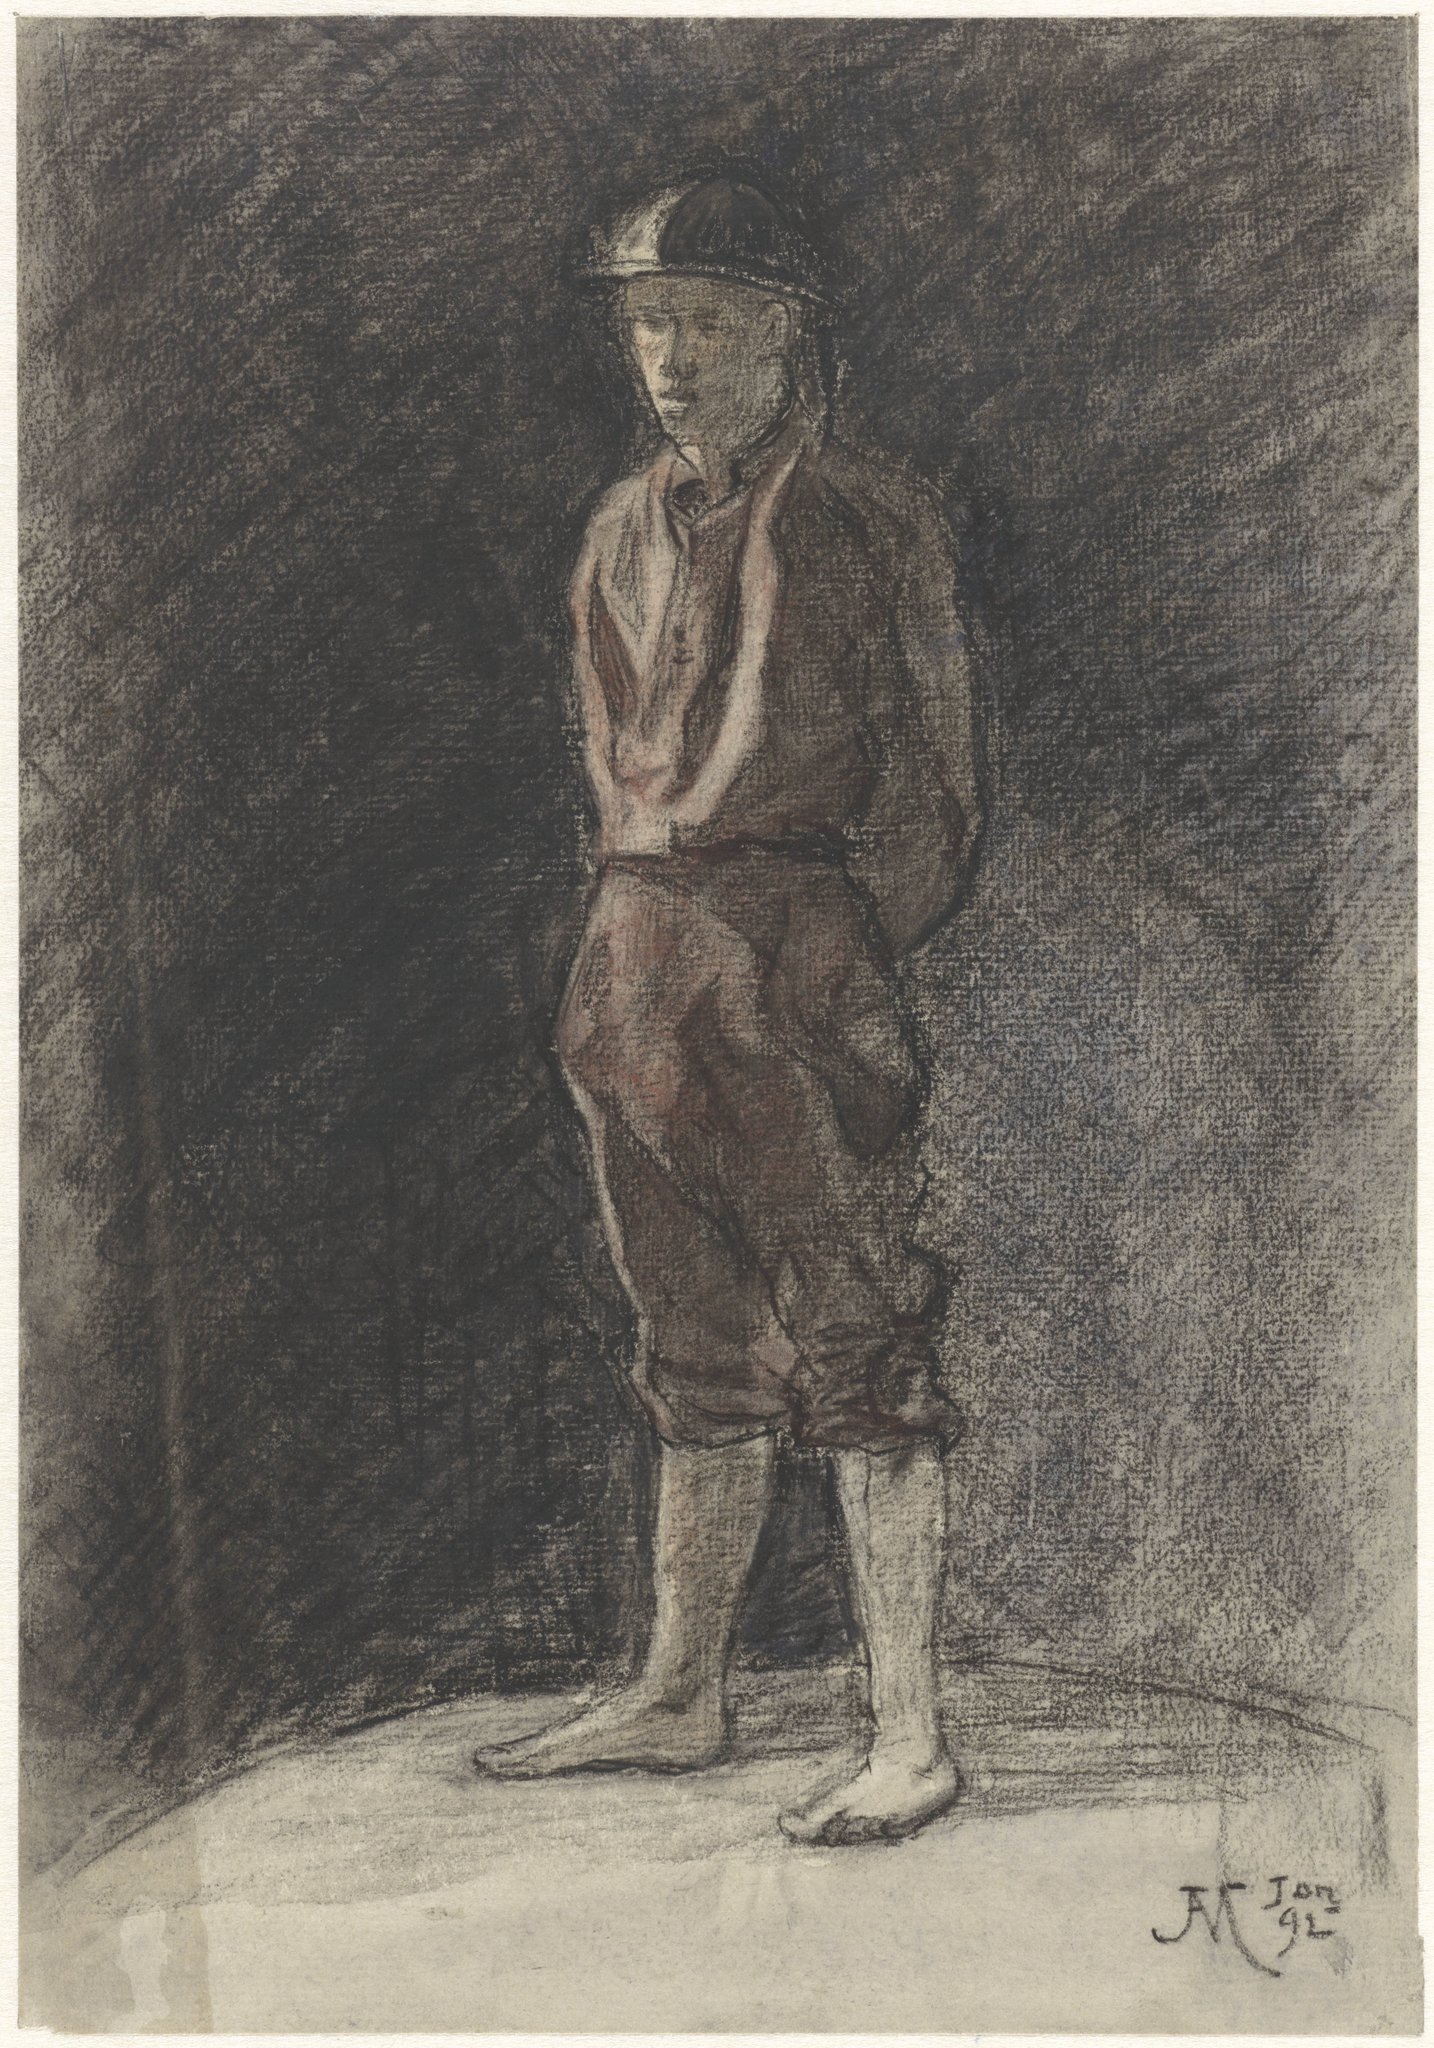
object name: drawing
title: Staande man met helm en opgerolde boekspijpen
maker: johannes abraham mondt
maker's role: draughtsman, print maker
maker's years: 1859-1941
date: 1801-1892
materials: chalk, paper